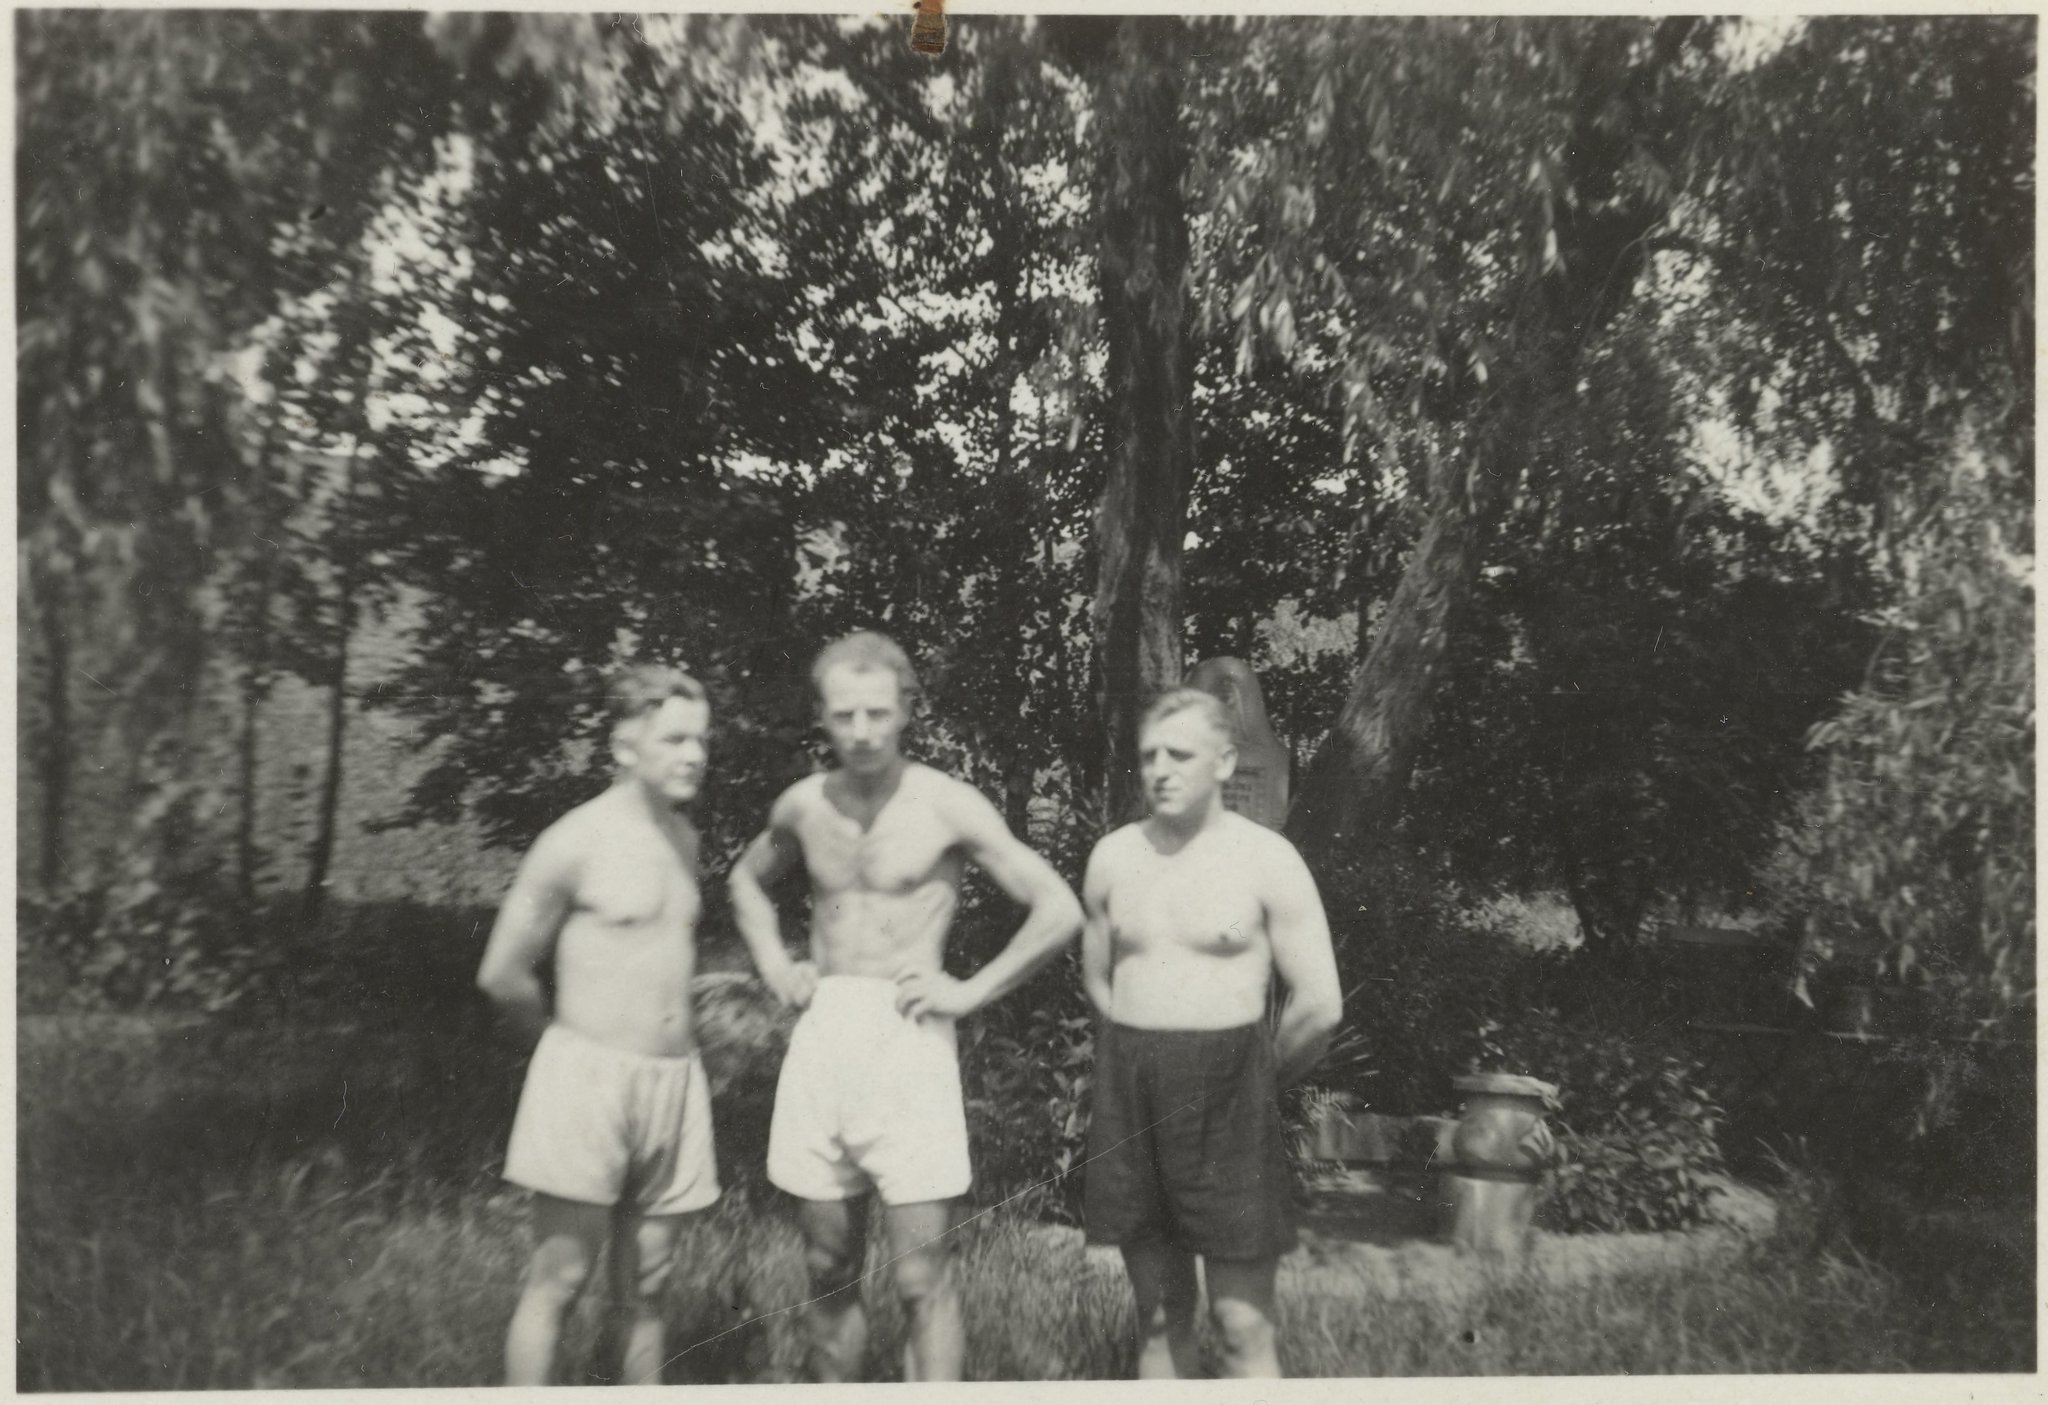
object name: photograph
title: Drie mannen in korte broeken en bloot bovenlijf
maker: Anonymous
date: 1940-1945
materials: photographic support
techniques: gelatin silver print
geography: czechoslovakia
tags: germany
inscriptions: stamp: ‘Drogenhaus Walter Glatzel Breslau 10 Rosenthalerstr. 24’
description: Drie mannen in korte broeken en bloot bovenlijf voor wat bomen, mogelijk in Breslau. Foto behorend bij album 'Kriegserinnerungen'.